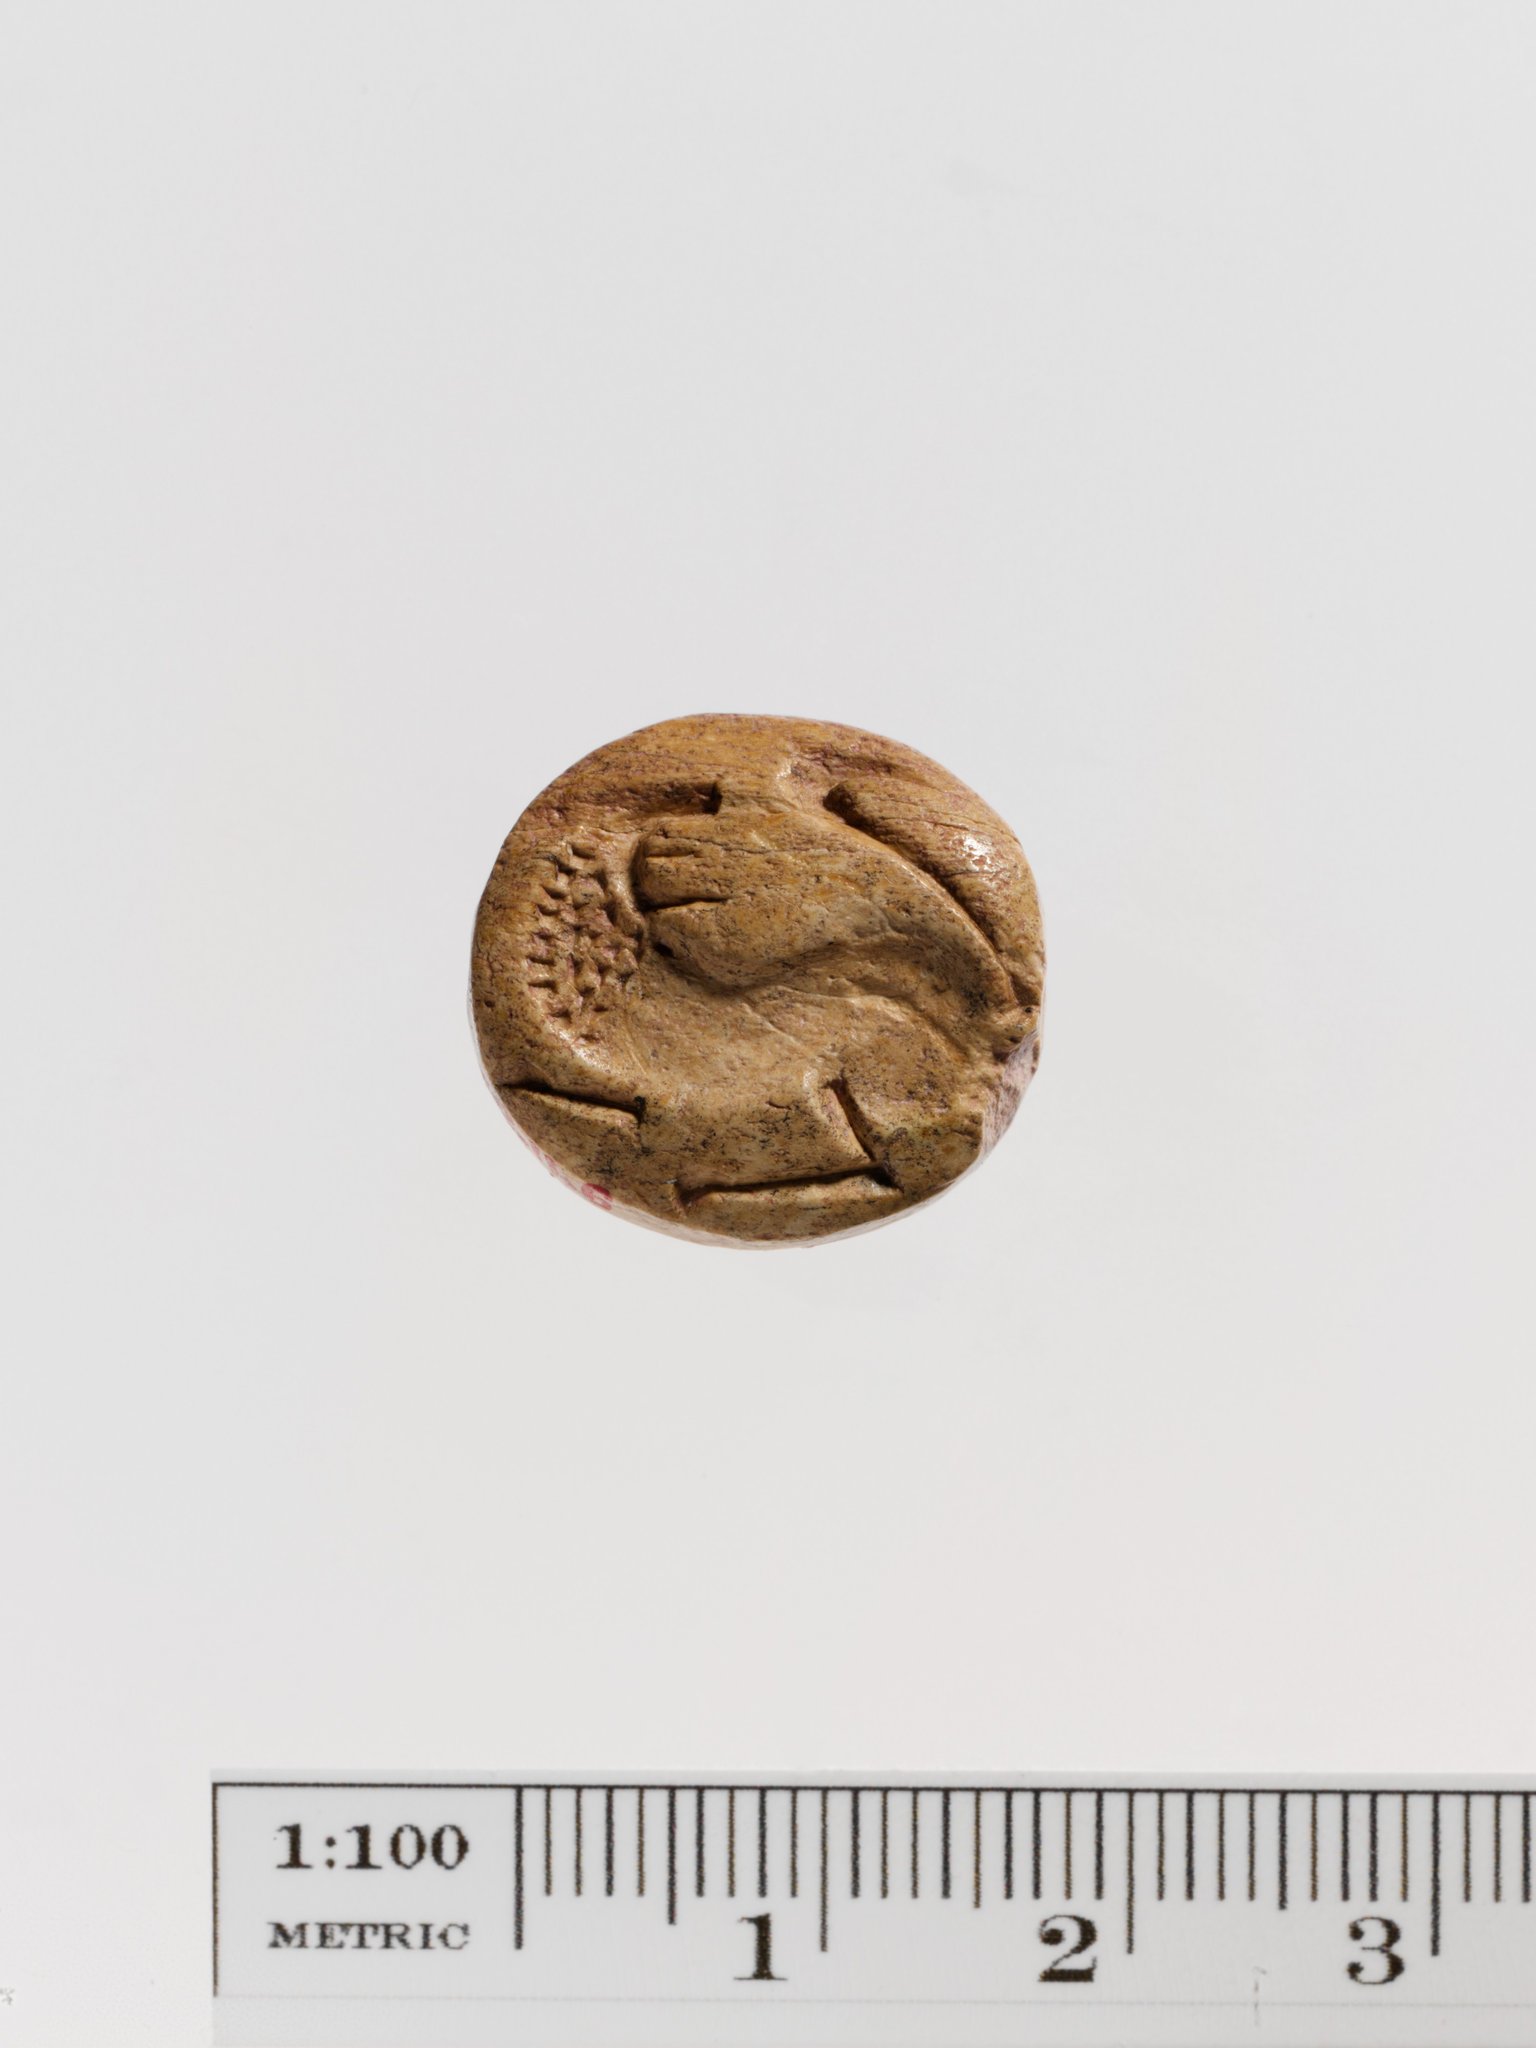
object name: intaglio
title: Steatite lentoid seal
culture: greek, melian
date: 700-668 BCE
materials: stone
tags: lions